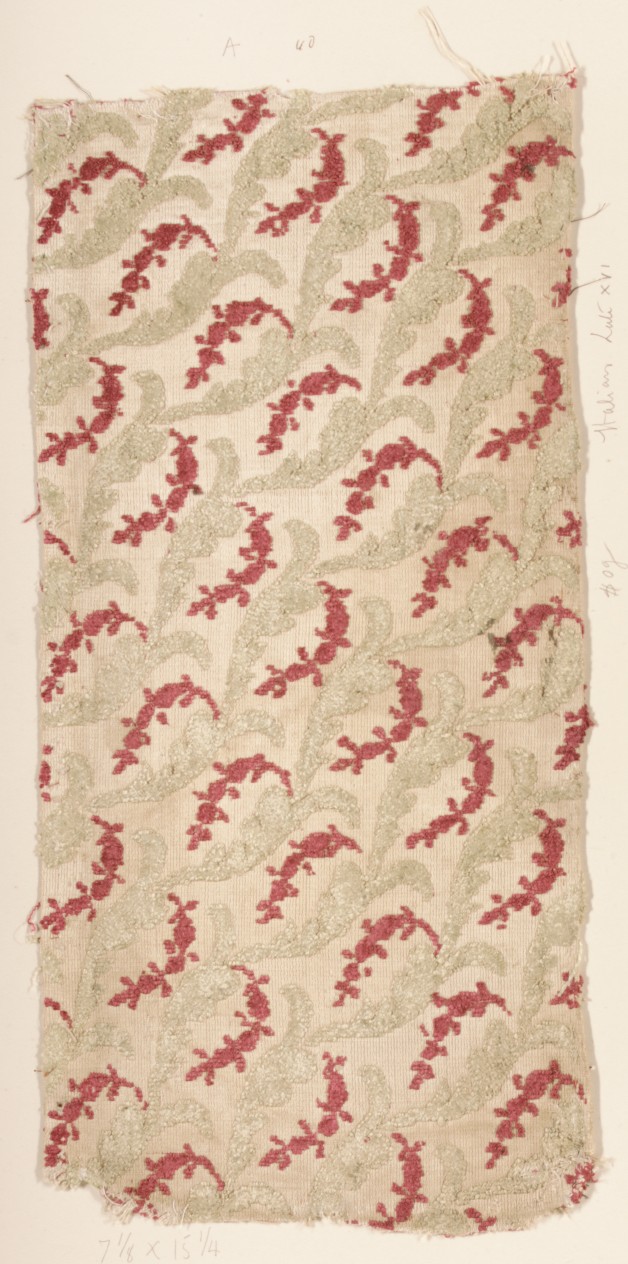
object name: fragment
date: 1567-1600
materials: silk